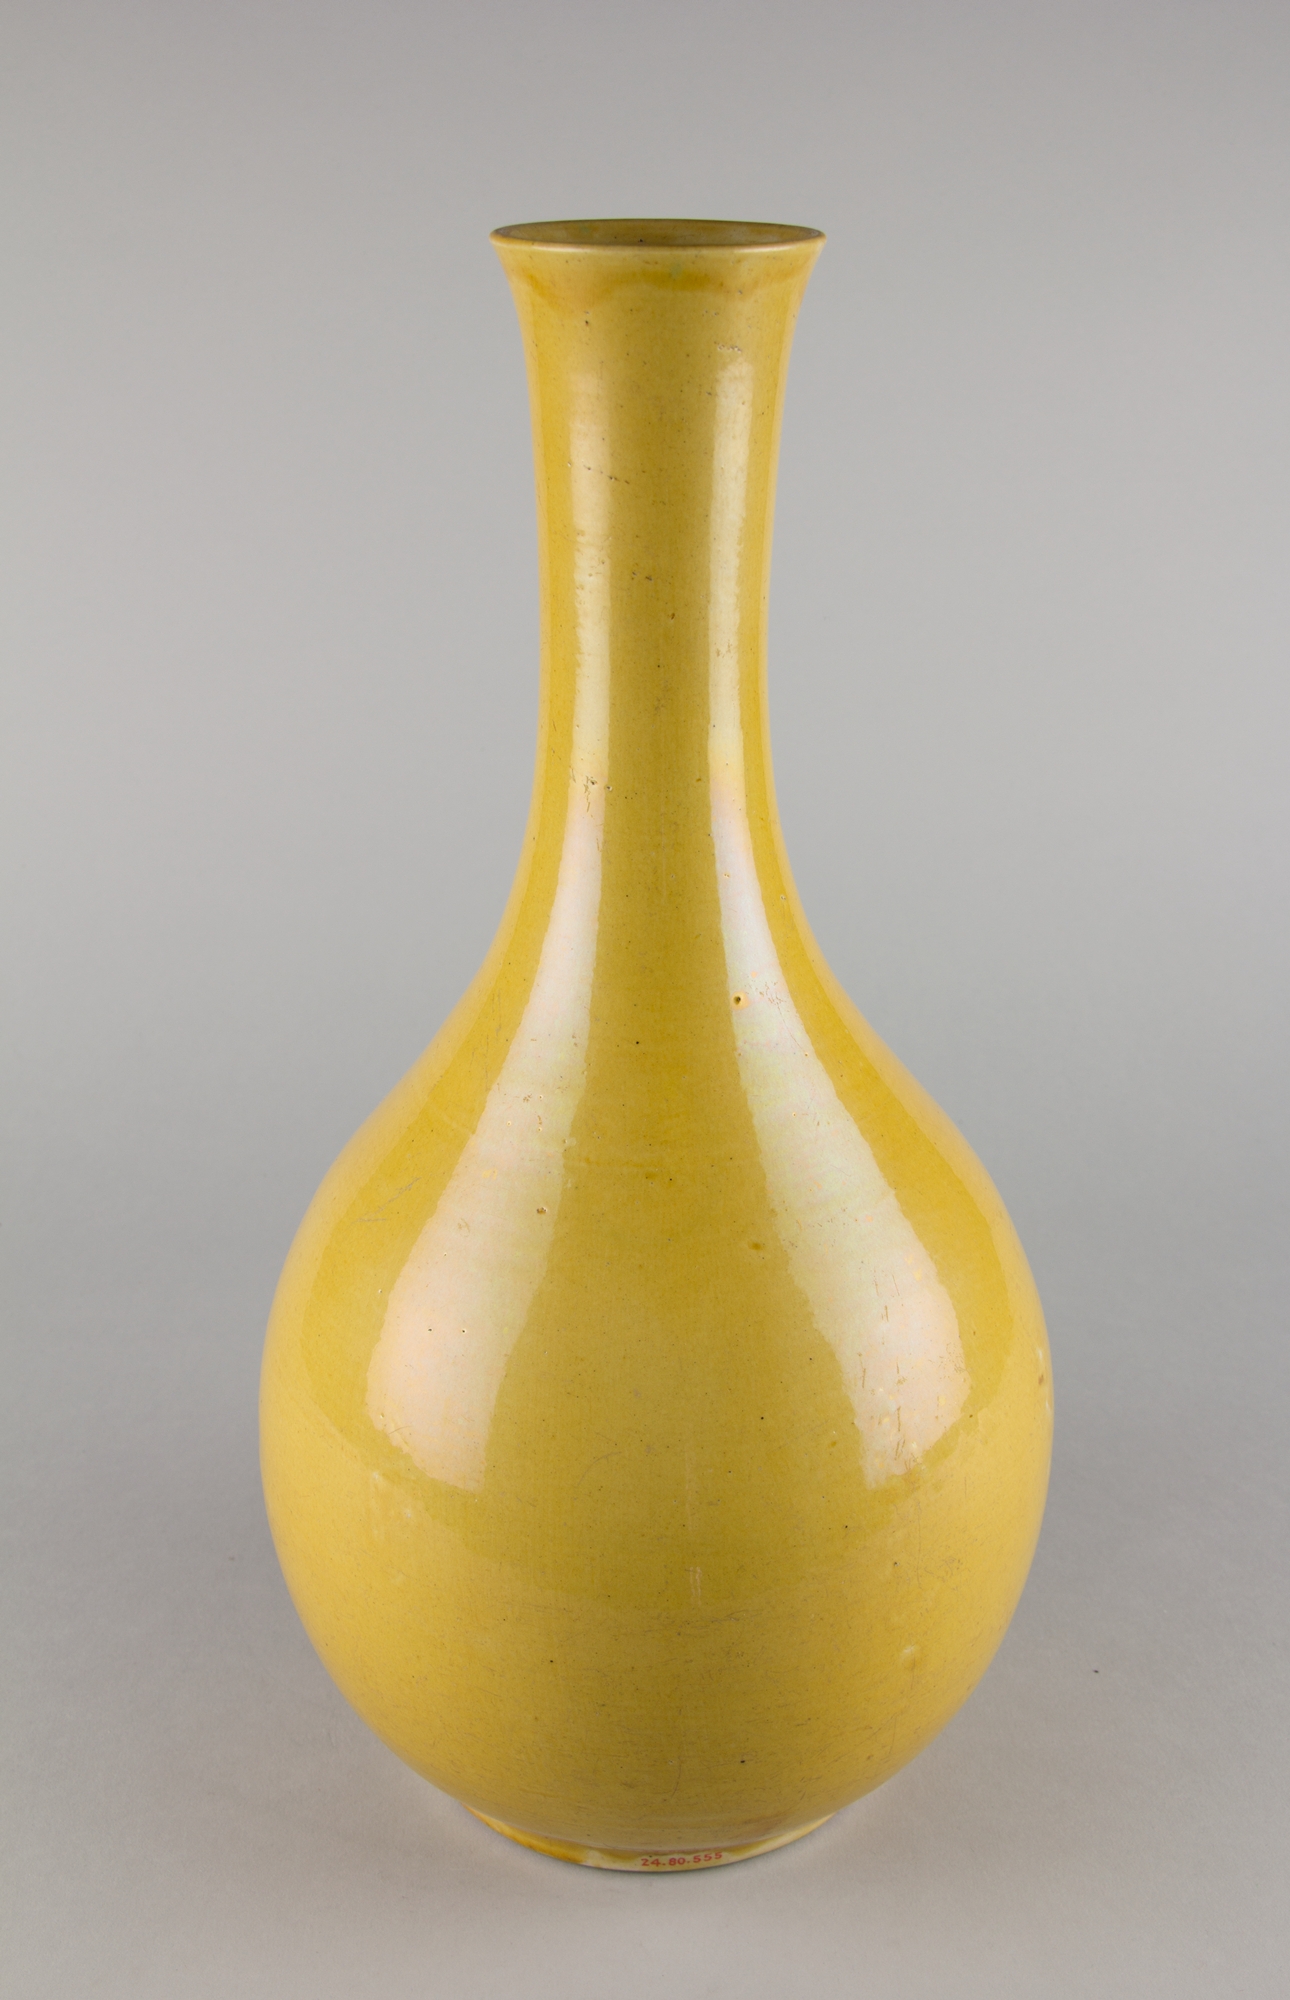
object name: bottle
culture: chinese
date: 1622-1722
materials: porcelain